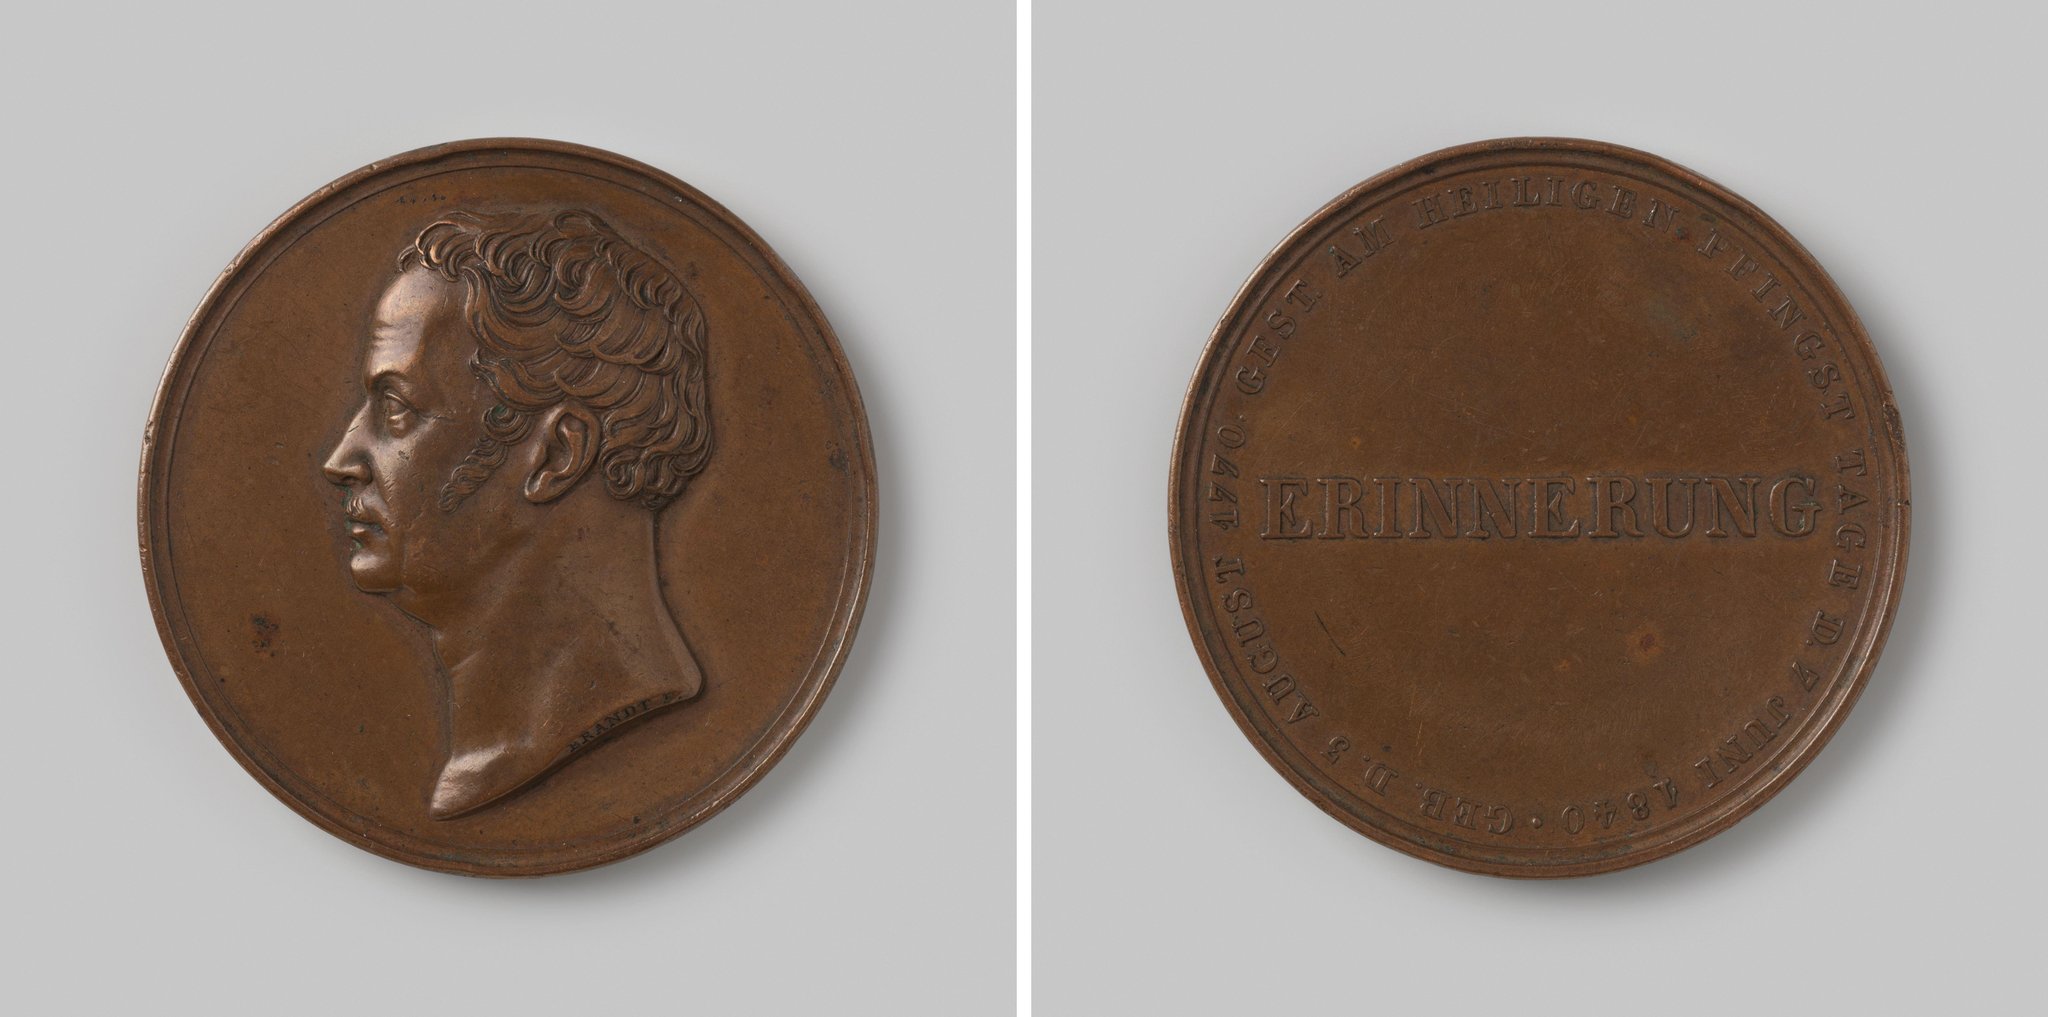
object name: history medal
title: Overlijden van Friedrich Wilhelm III van Pruissen 1840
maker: brandt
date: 1840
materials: copper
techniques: striking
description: Bronzen penning, op de voorzijde het portret van Friedrich naar links, op de keerzijde één regel tekst met omschrift.